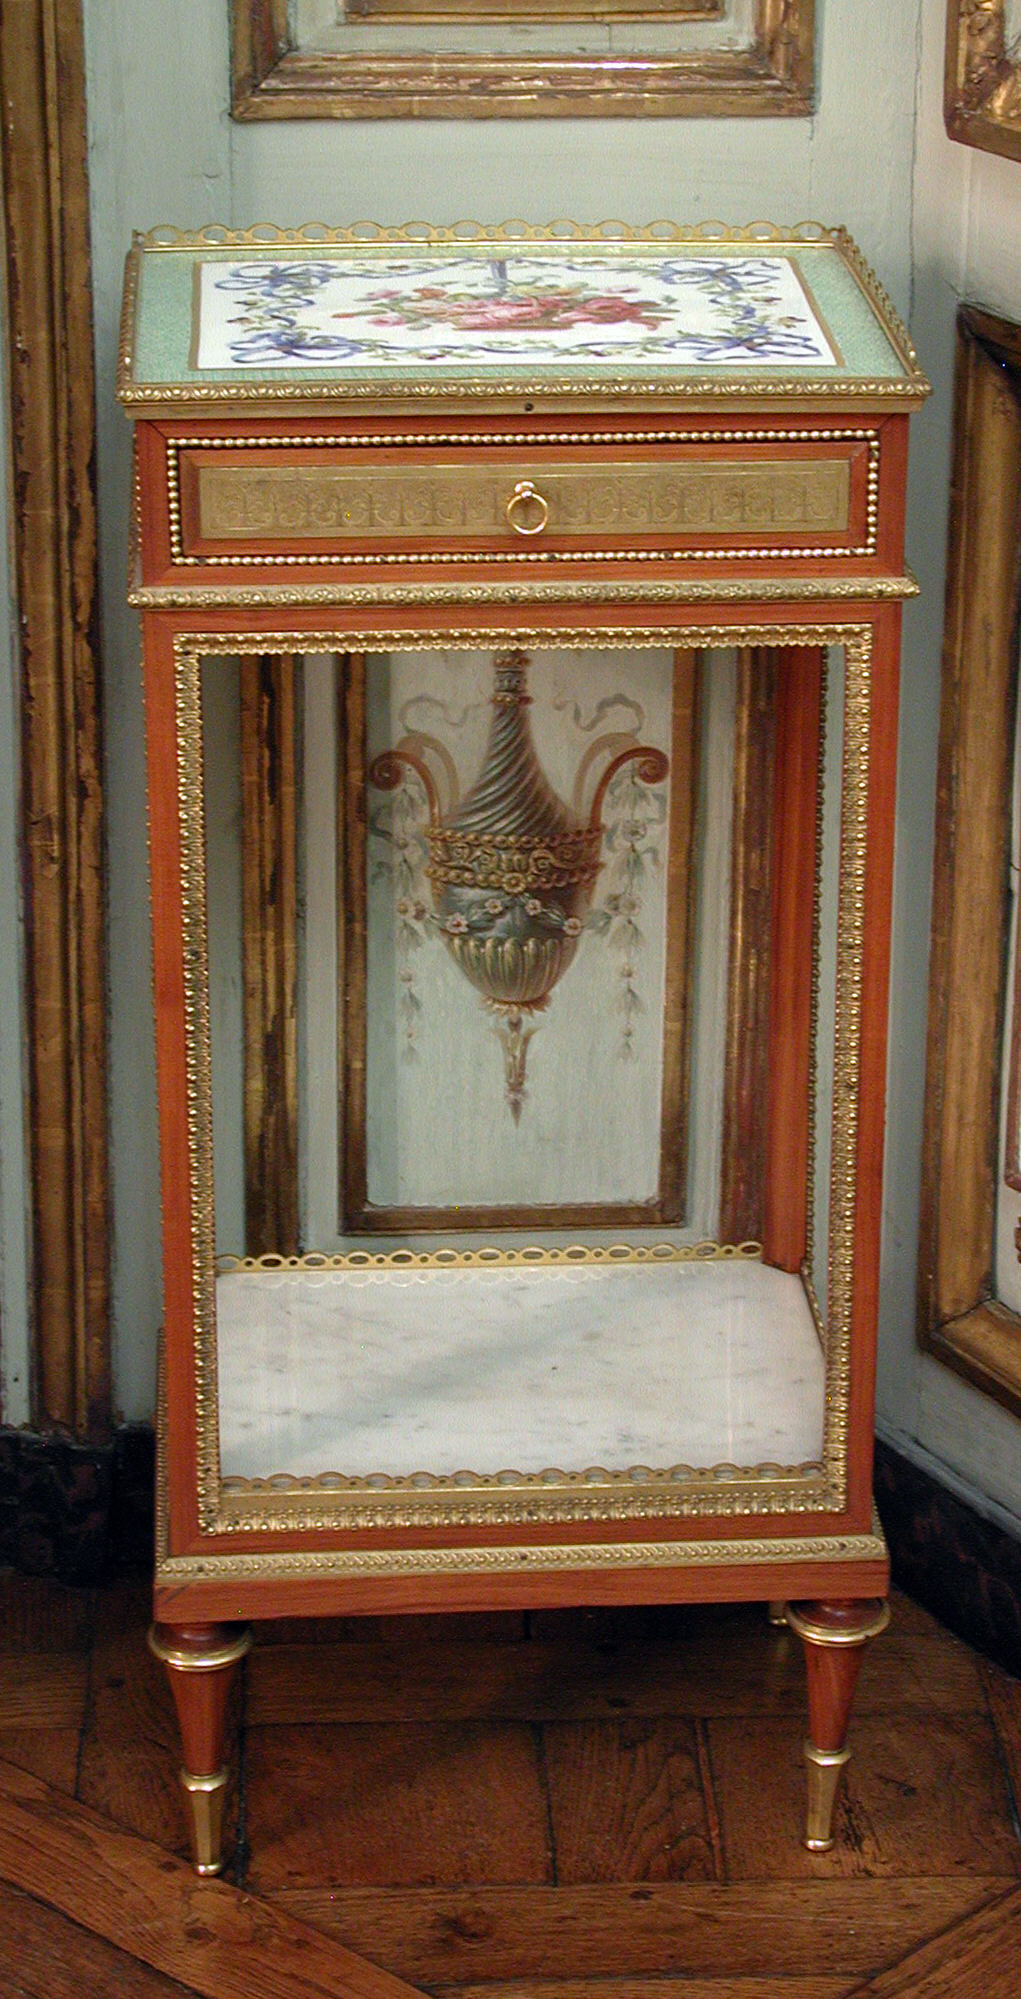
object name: writing and eating table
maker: martin carlin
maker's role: maker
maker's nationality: french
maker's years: 1725-1785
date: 1780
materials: gilt bronze, marble, wood, soft paste porcelain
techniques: veneering